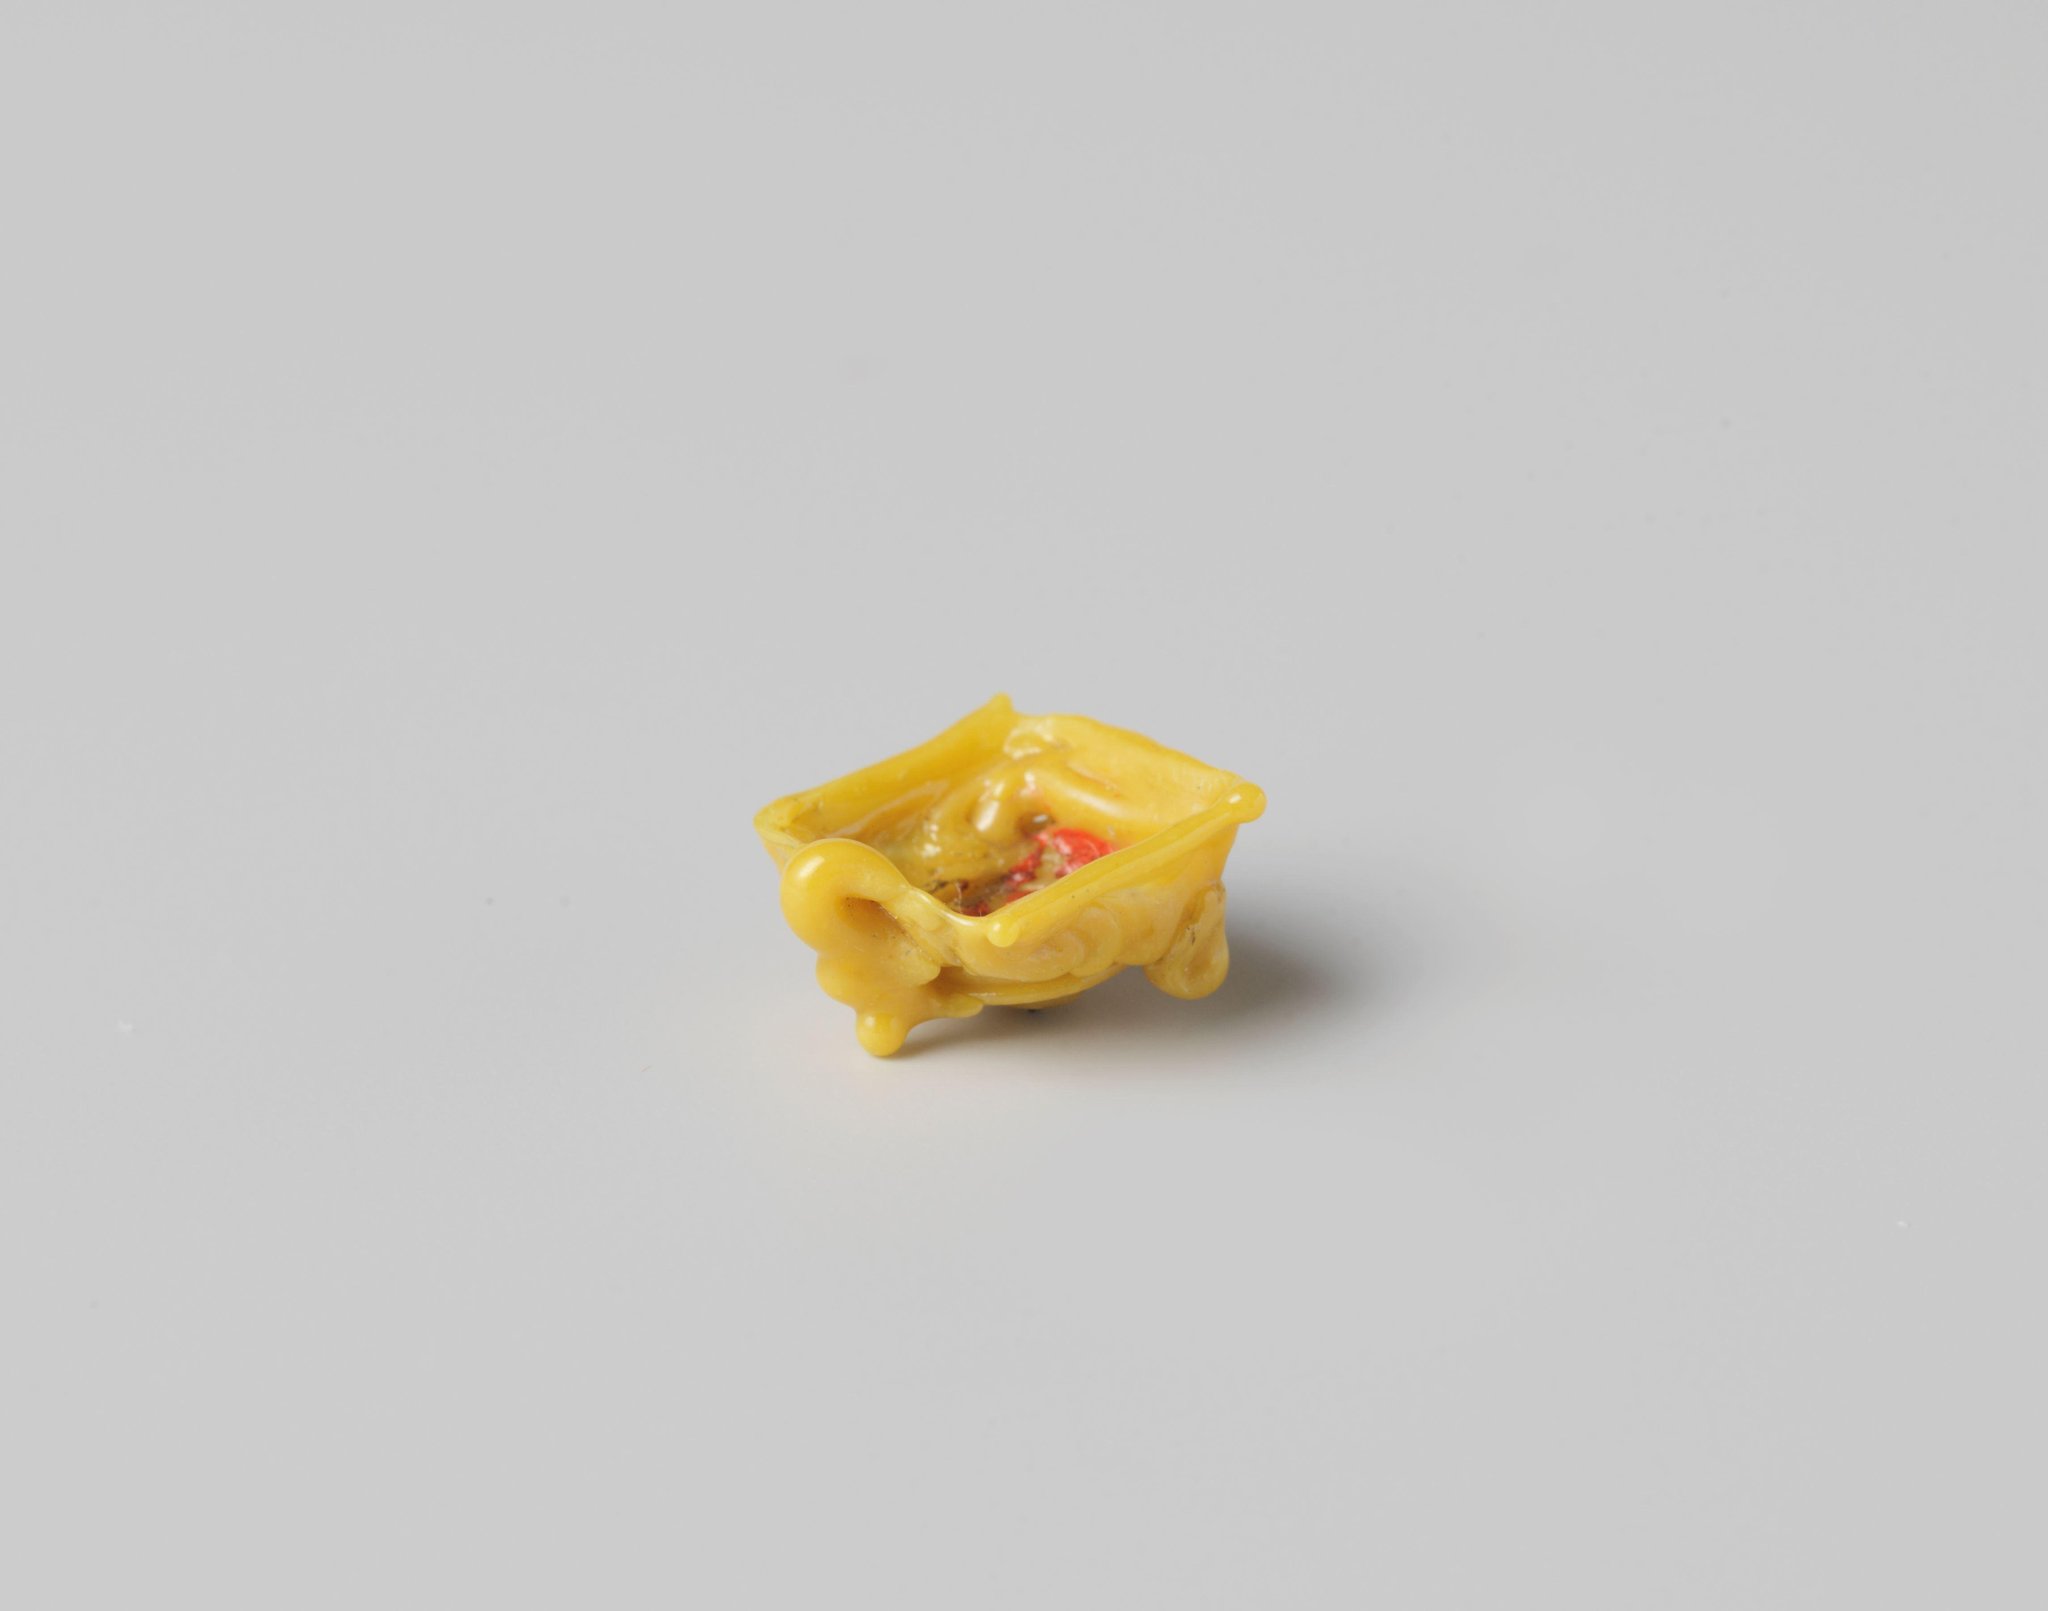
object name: miniature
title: Vuurtest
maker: Anonymous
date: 1675-1699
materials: glass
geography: amsterdam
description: Drie vuurtesten van geel glas op drie poten met oor, vervaardigd van massieve glasmassa; binnenin resten van rode verf.